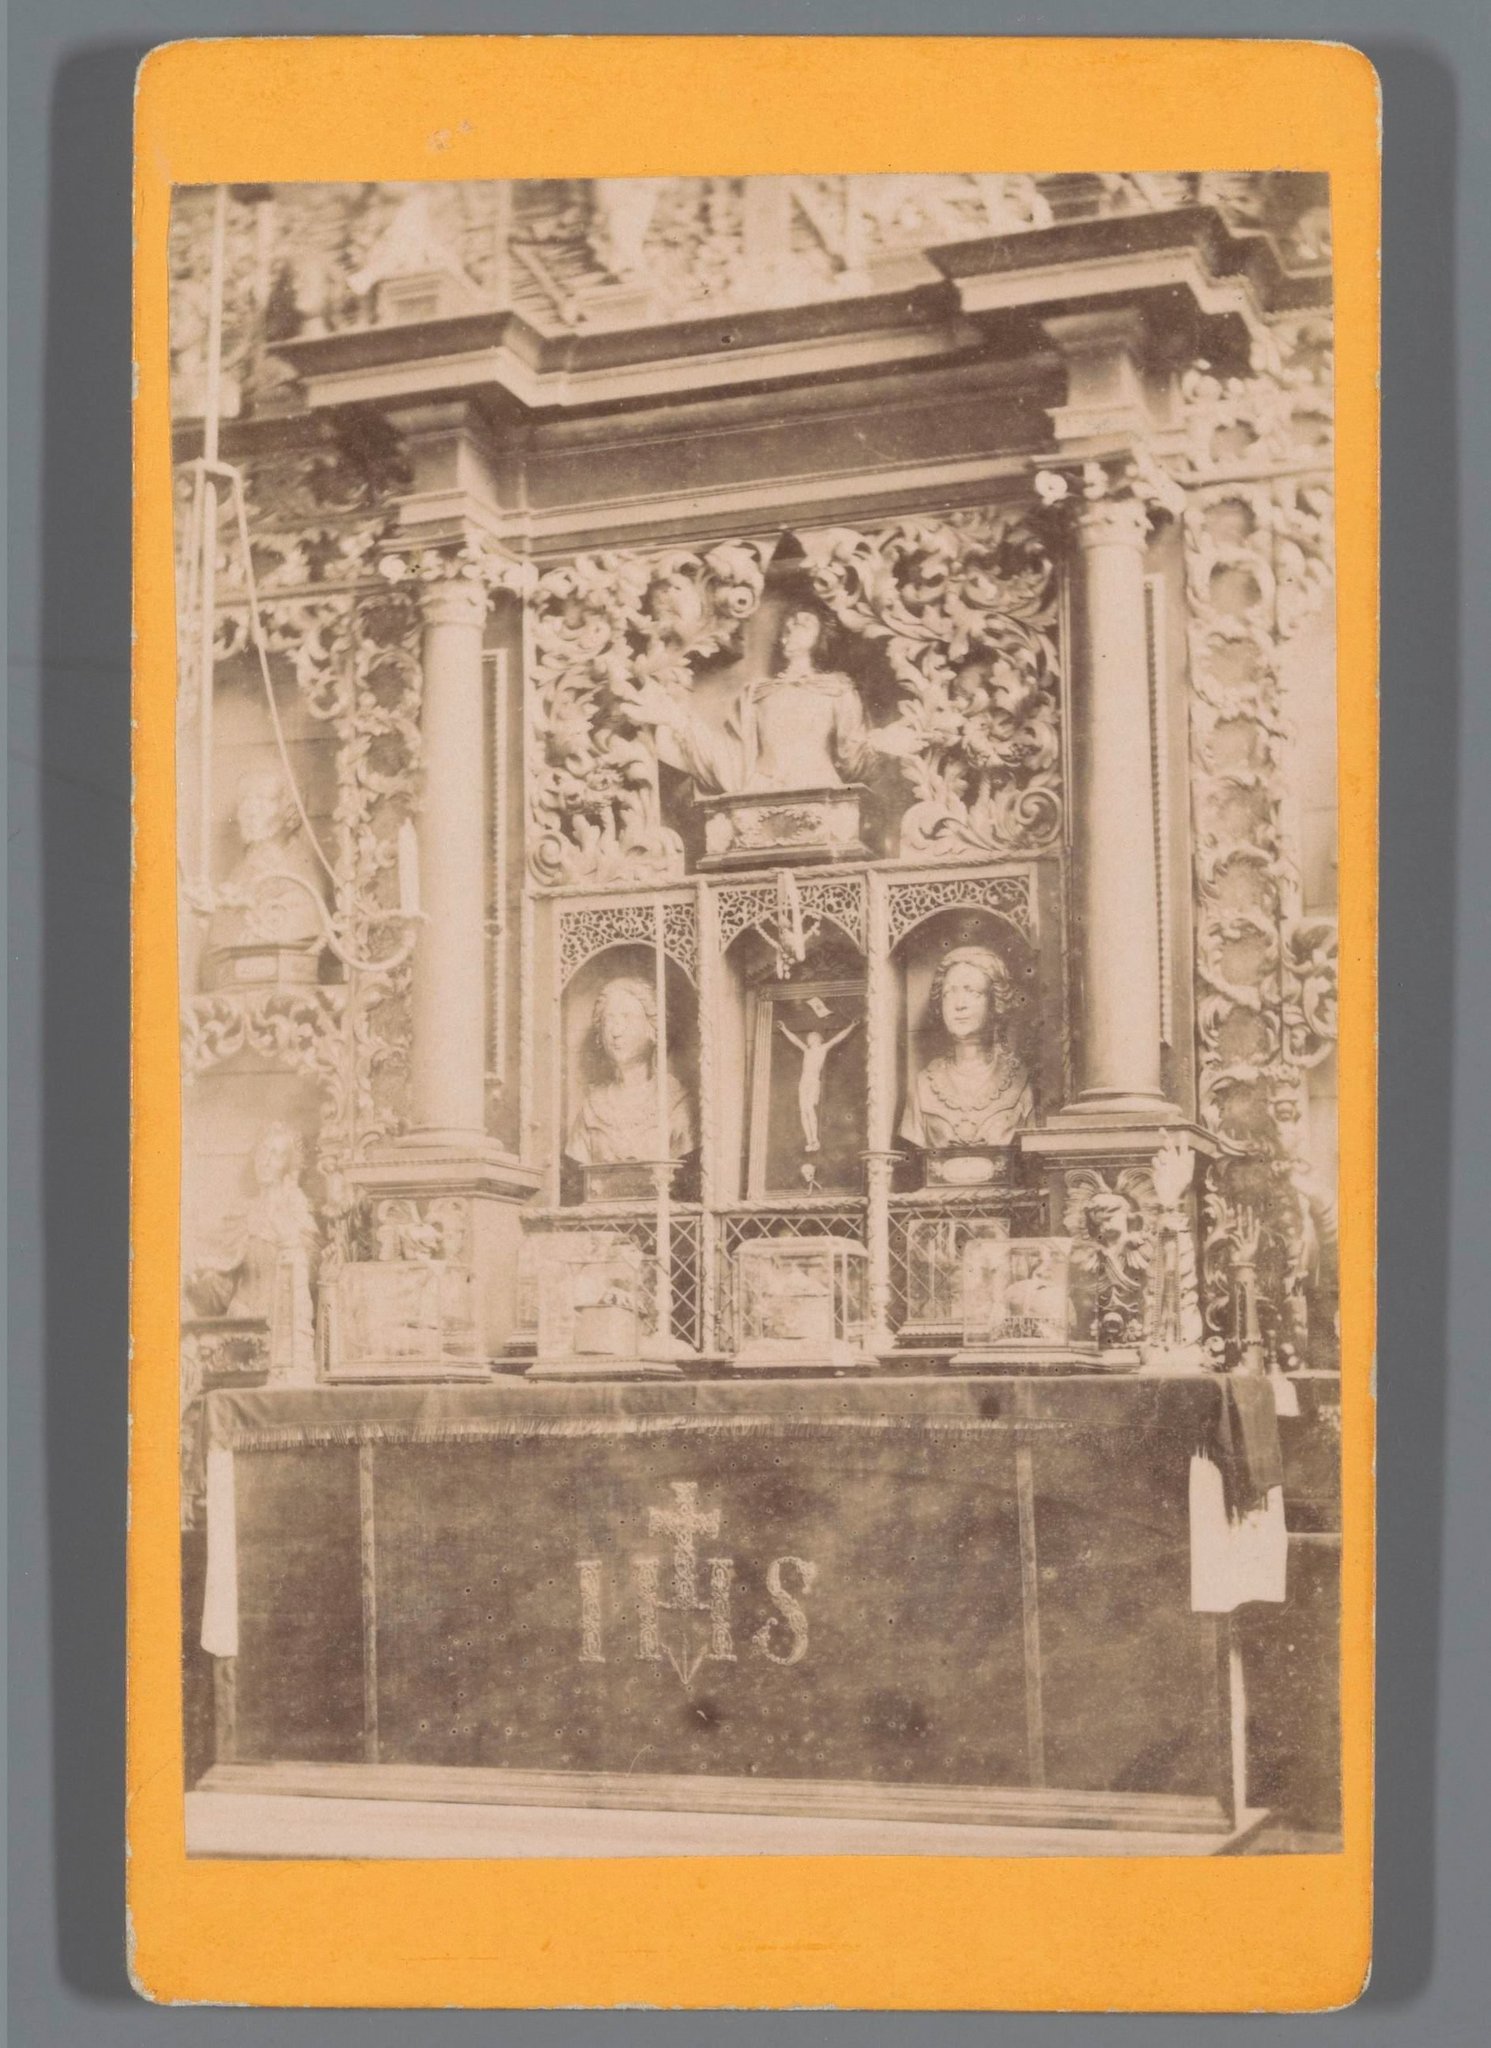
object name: carte de visite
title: Goldene Kammer in St. Ursula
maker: theodor creifelds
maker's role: publisher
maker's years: 1815-1875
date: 1855-1875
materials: cardboard, paper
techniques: albumen print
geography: cologne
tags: parts of church interior (crypt)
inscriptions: inscription: ‘Photographische Anstalt/ von/ Th: Creifelds/ in/ CÖLN./ Domkloster.’, number: ‘-555-’